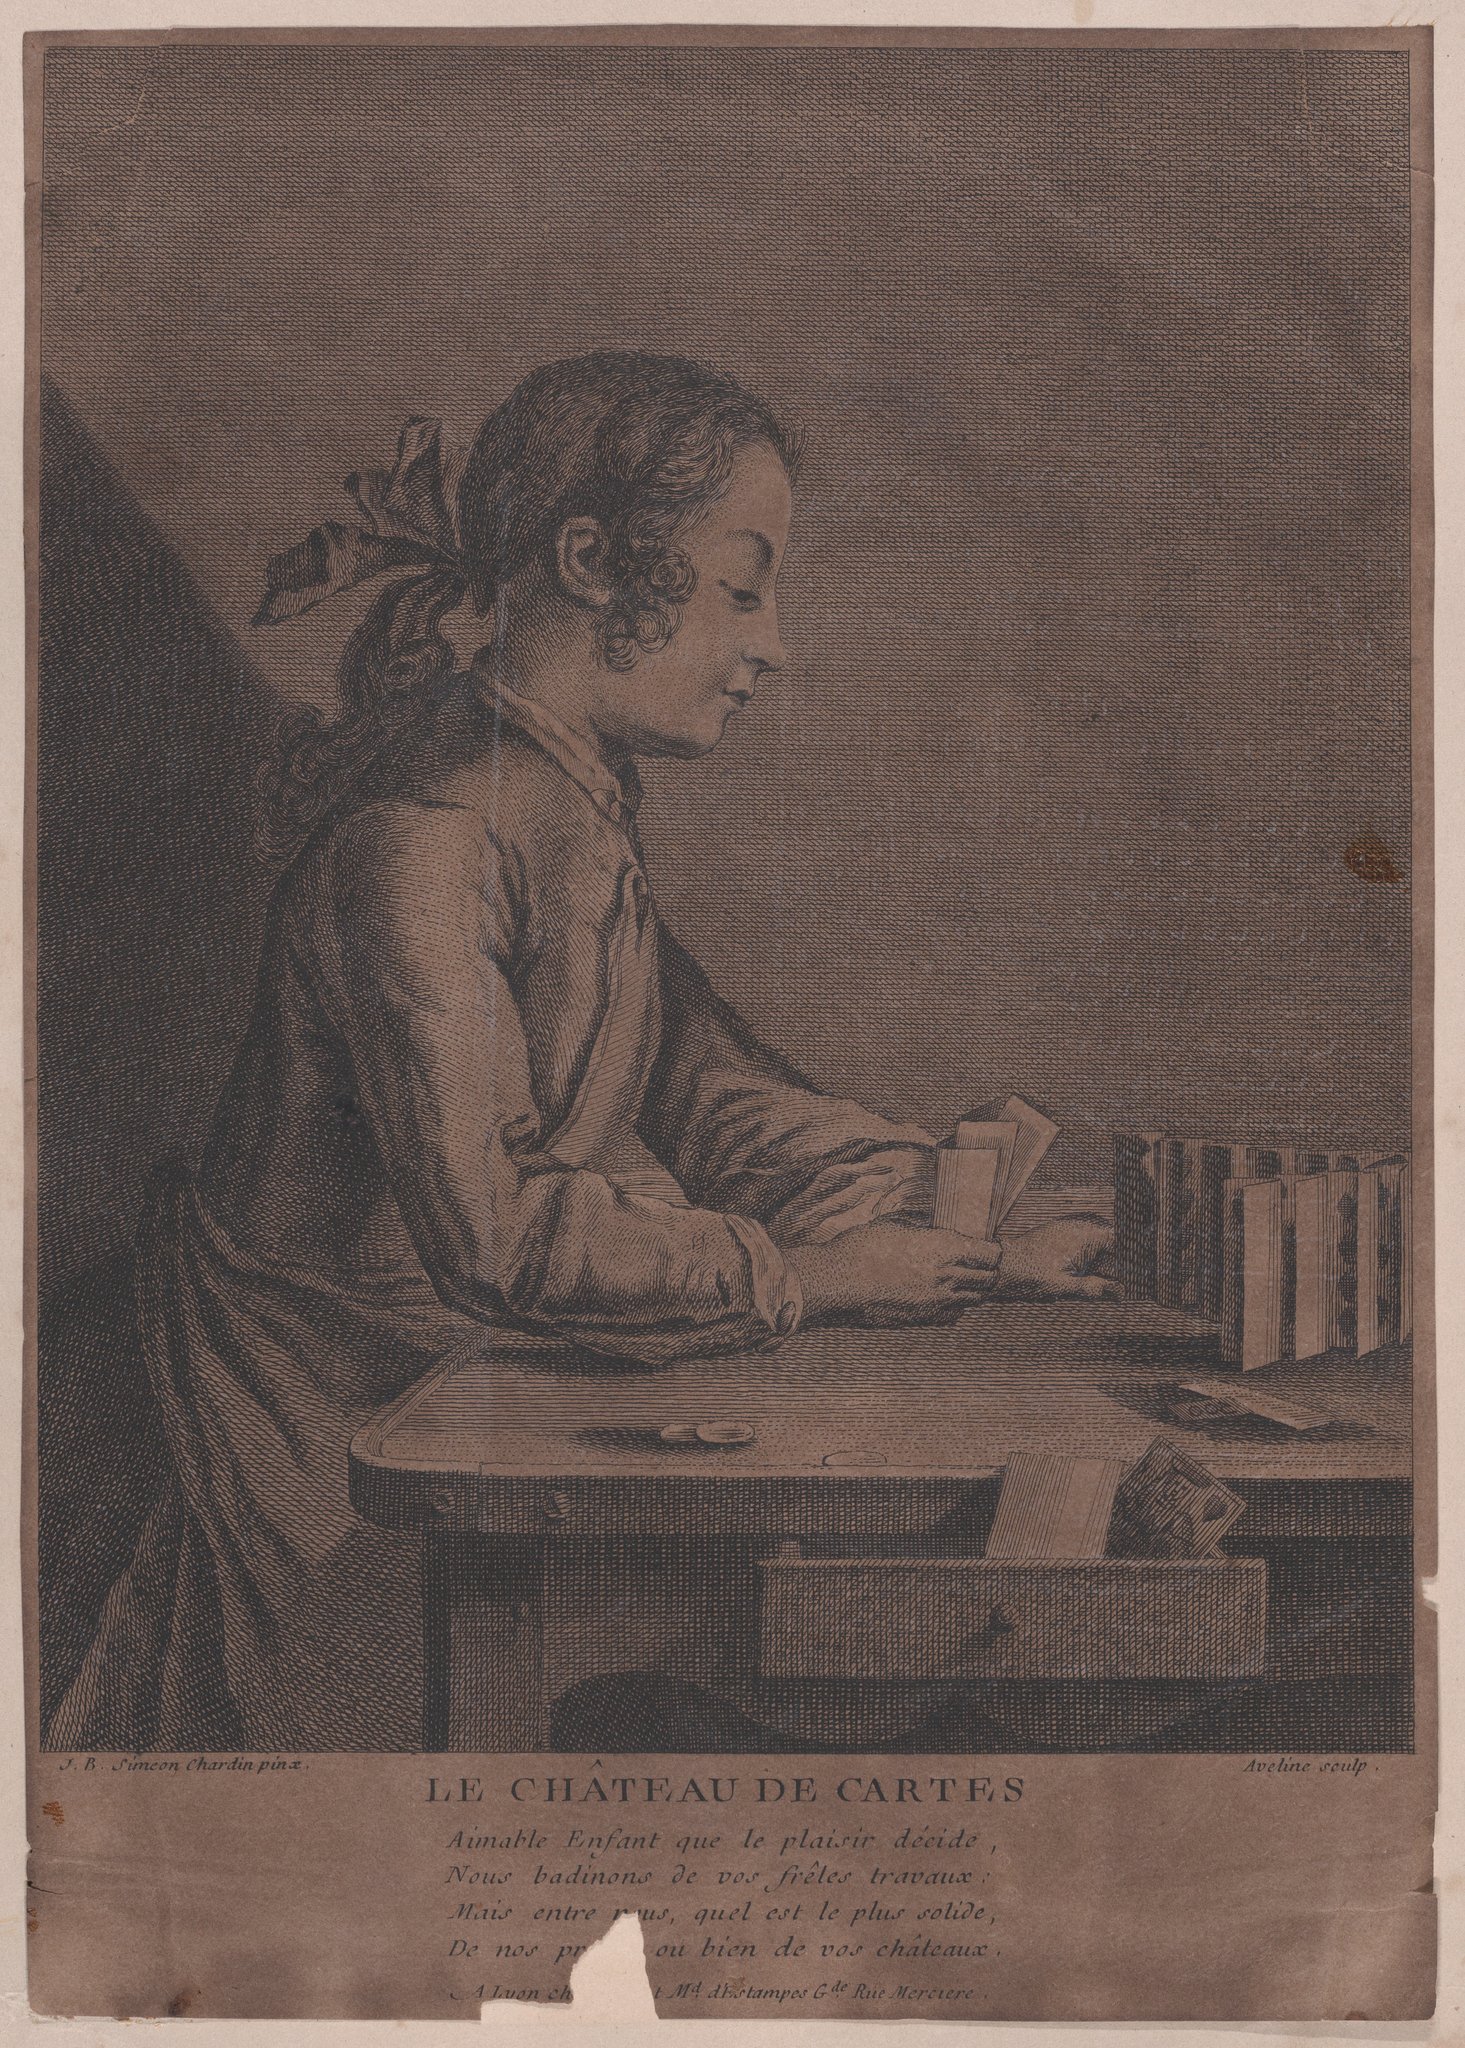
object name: print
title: The Castle of Cards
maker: pierre alexandre aveline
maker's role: artist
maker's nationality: french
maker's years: 1702-1760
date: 1744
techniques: engraving, etching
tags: boys,playing cards,tables